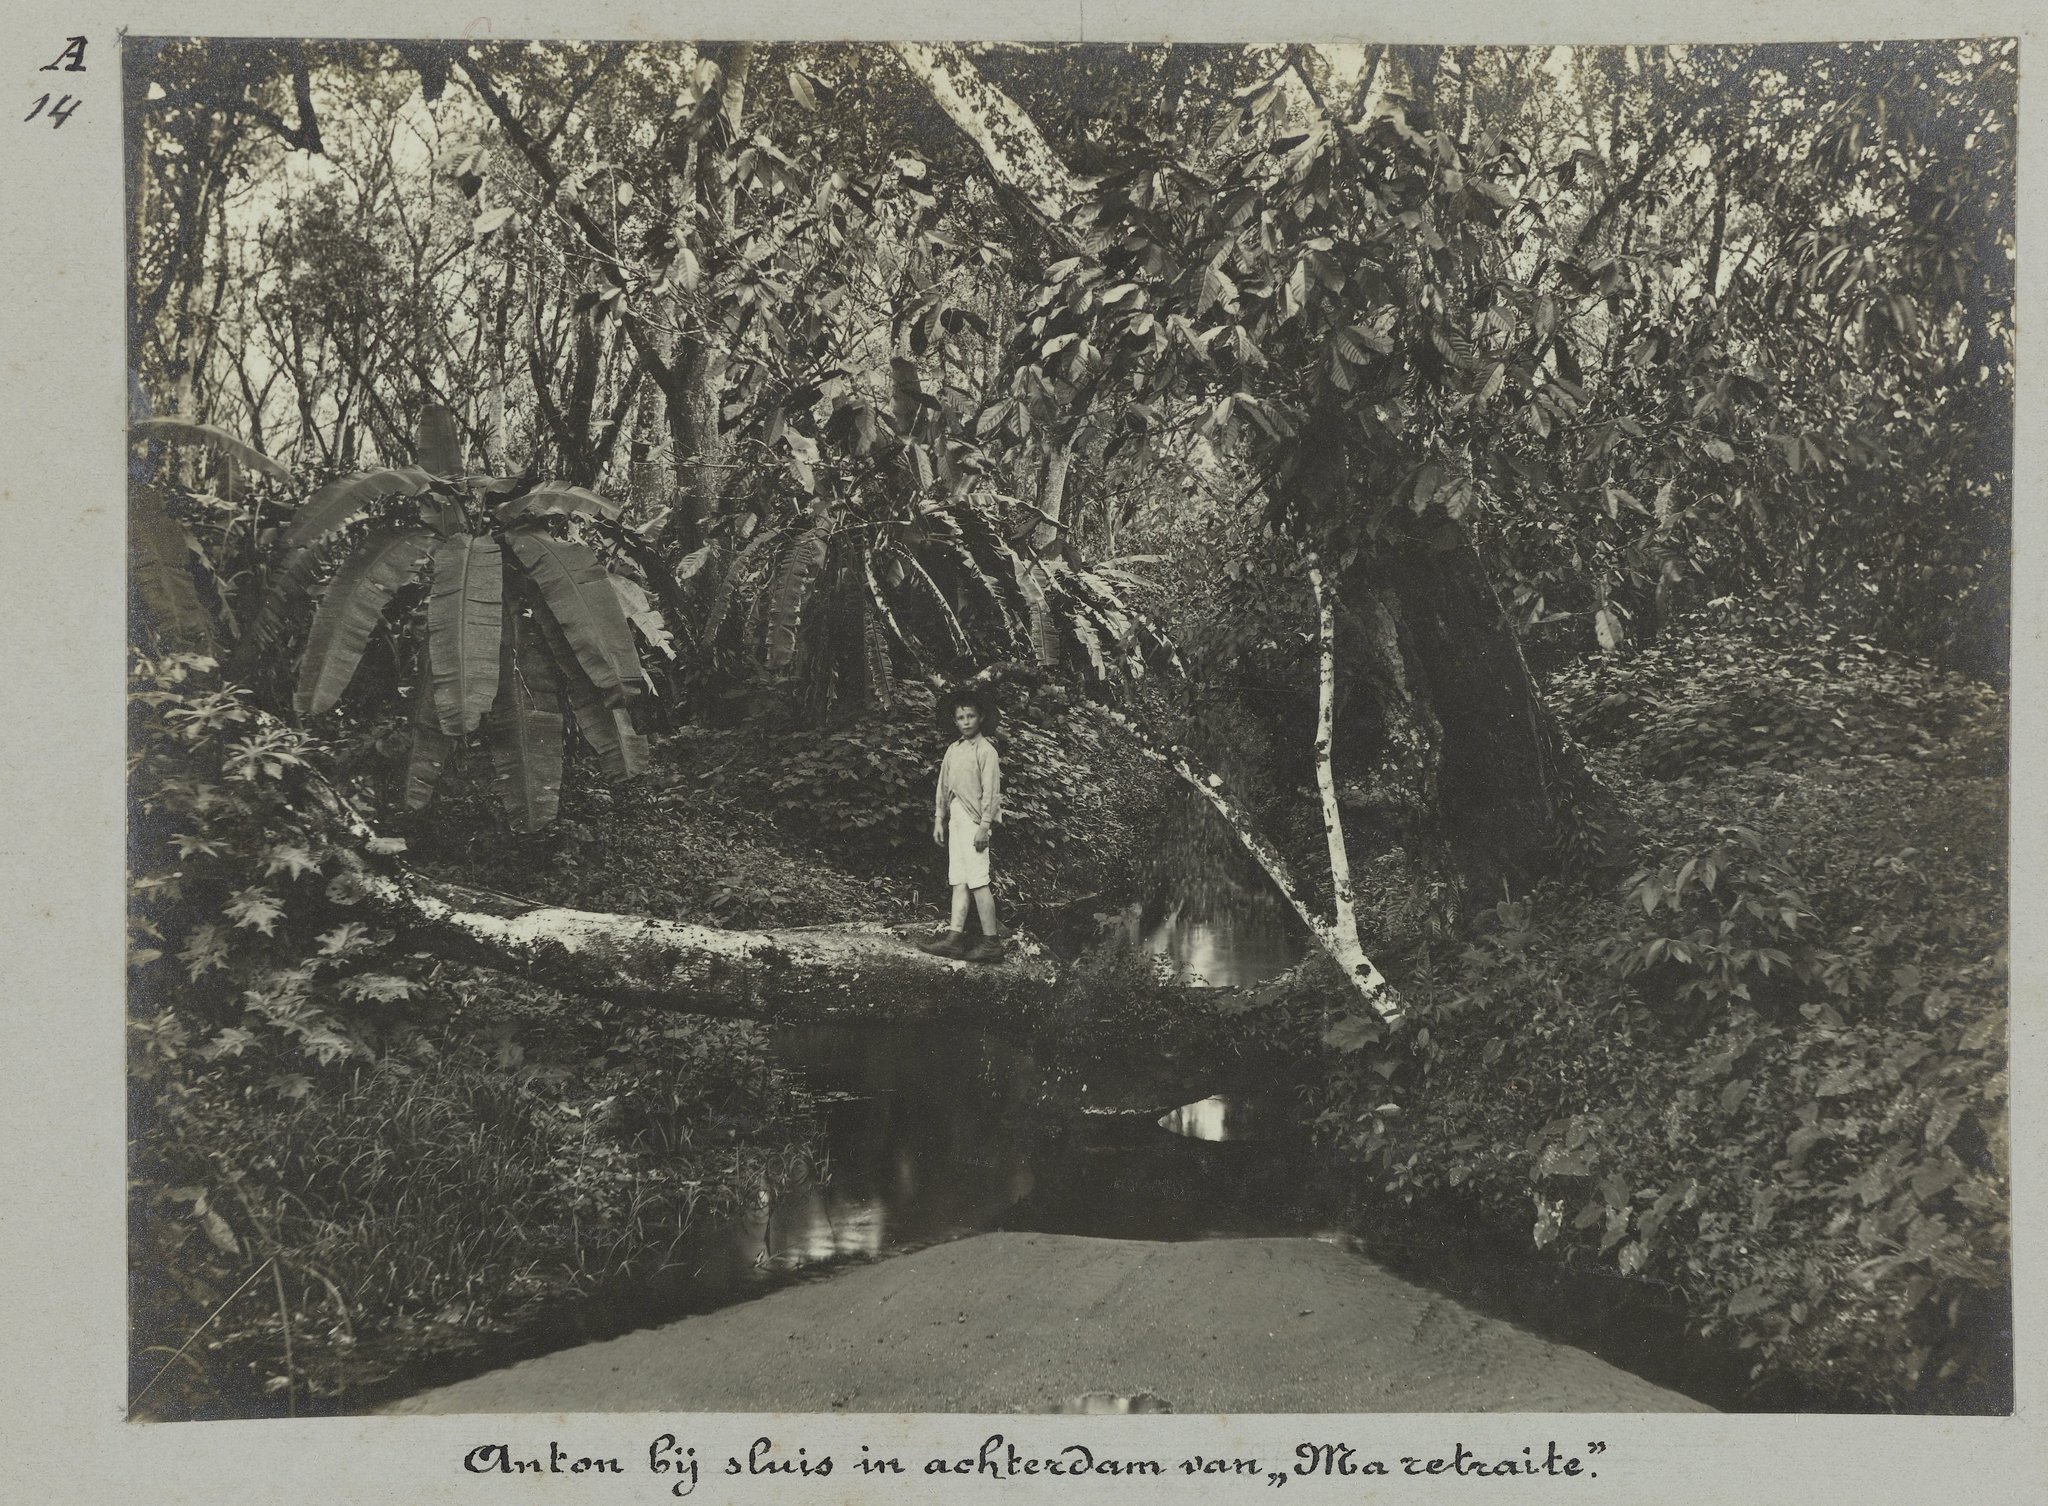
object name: photograph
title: Anton bij sluis in achterdam van "Ma retraite"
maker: hendrik doijer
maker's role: engineer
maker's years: 1863-1925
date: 1903-1910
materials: photographic support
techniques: gelatin silver print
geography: suriname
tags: suriname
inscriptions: inscription: ‘A14 / Anton bij sluis in achterdam van "Ma retraite".’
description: De Nederlandse jongen Anton staande op een boom bij de sluis op het terrein van de plantage Ma Retraite. Onderdeel van het fotoalbum Souvenir de Voyage (deel 1), over het leven van de familie Doijer in en rond de plantage Ma Retraite in Suriname in de jaren 1903-1910.